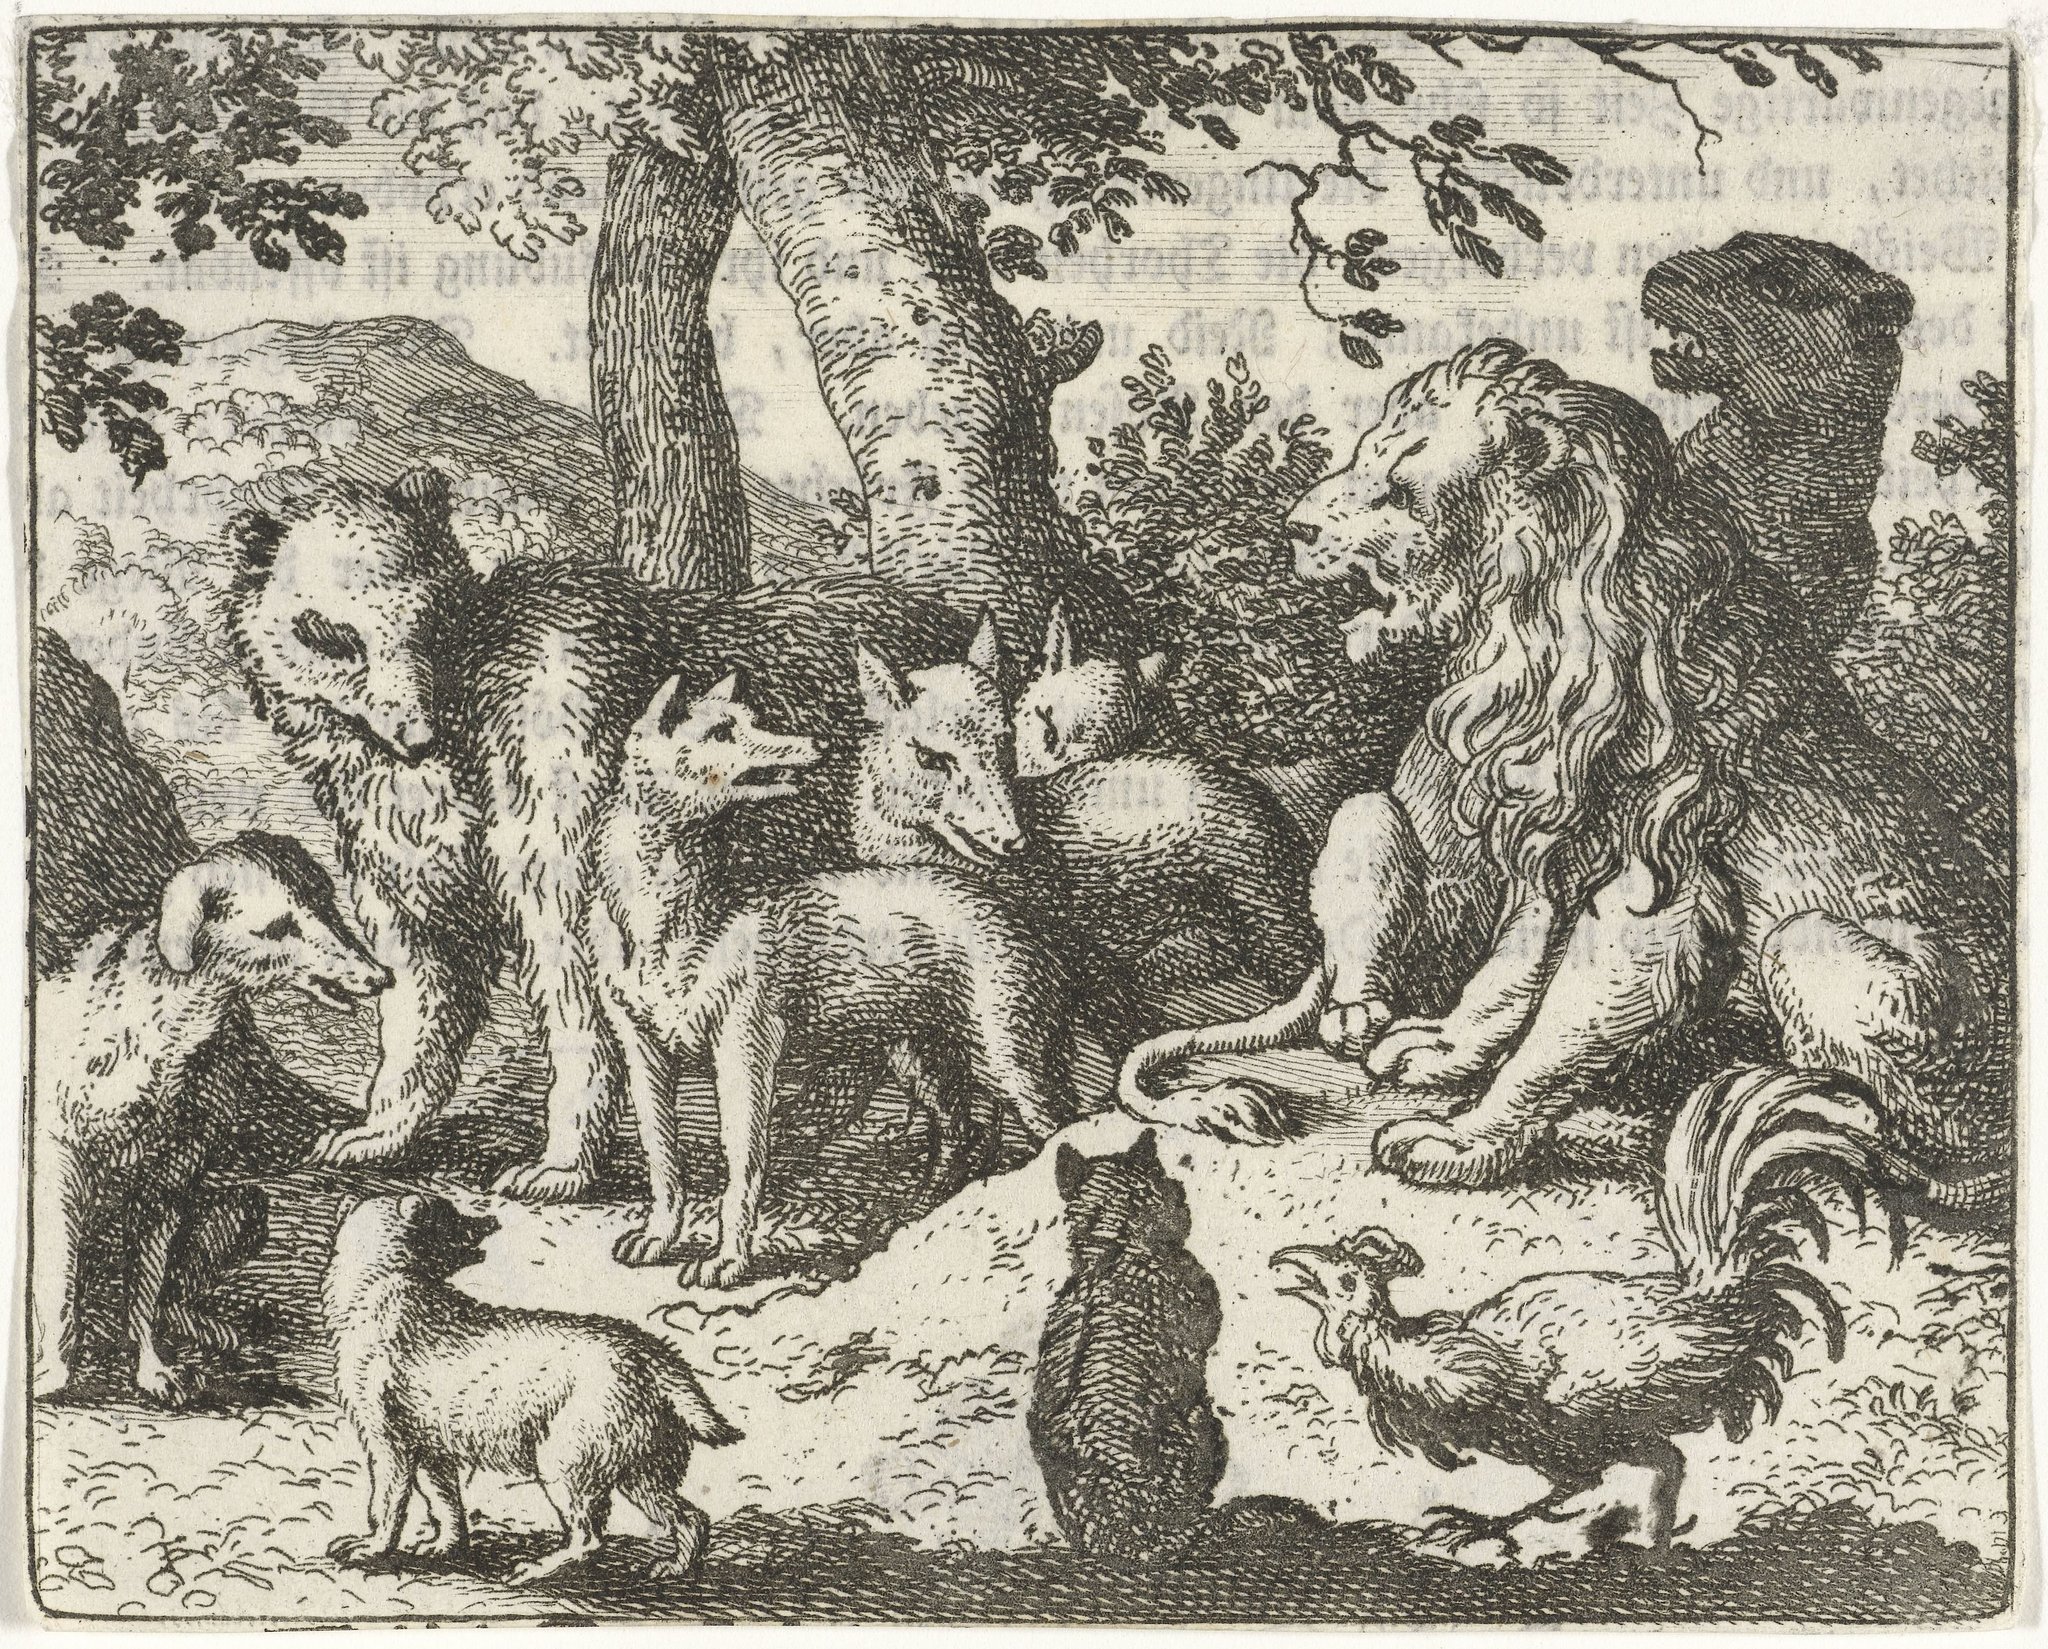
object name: print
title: Reinaert de vos verontschuldigt zich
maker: allaert van everdingen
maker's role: draughtsman, painter, print maker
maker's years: 1621-1675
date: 1665-1675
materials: paper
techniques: etching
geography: netherlands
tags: fable of reynard the fox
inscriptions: collector's mark: Lugt 2228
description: Reinaert de vos verontschuldigt zich in het bijzijn van alle dieren tegenover de leeuw, koning Nobel. Op de voorgrond Tibert de kat, op de rug gezien, geflankeerd door Canteclaer de haan en Grimbeert de das. Op de achterkant van de prent een Duits tekstfragment uit het verhaal van Reinaert de vos.